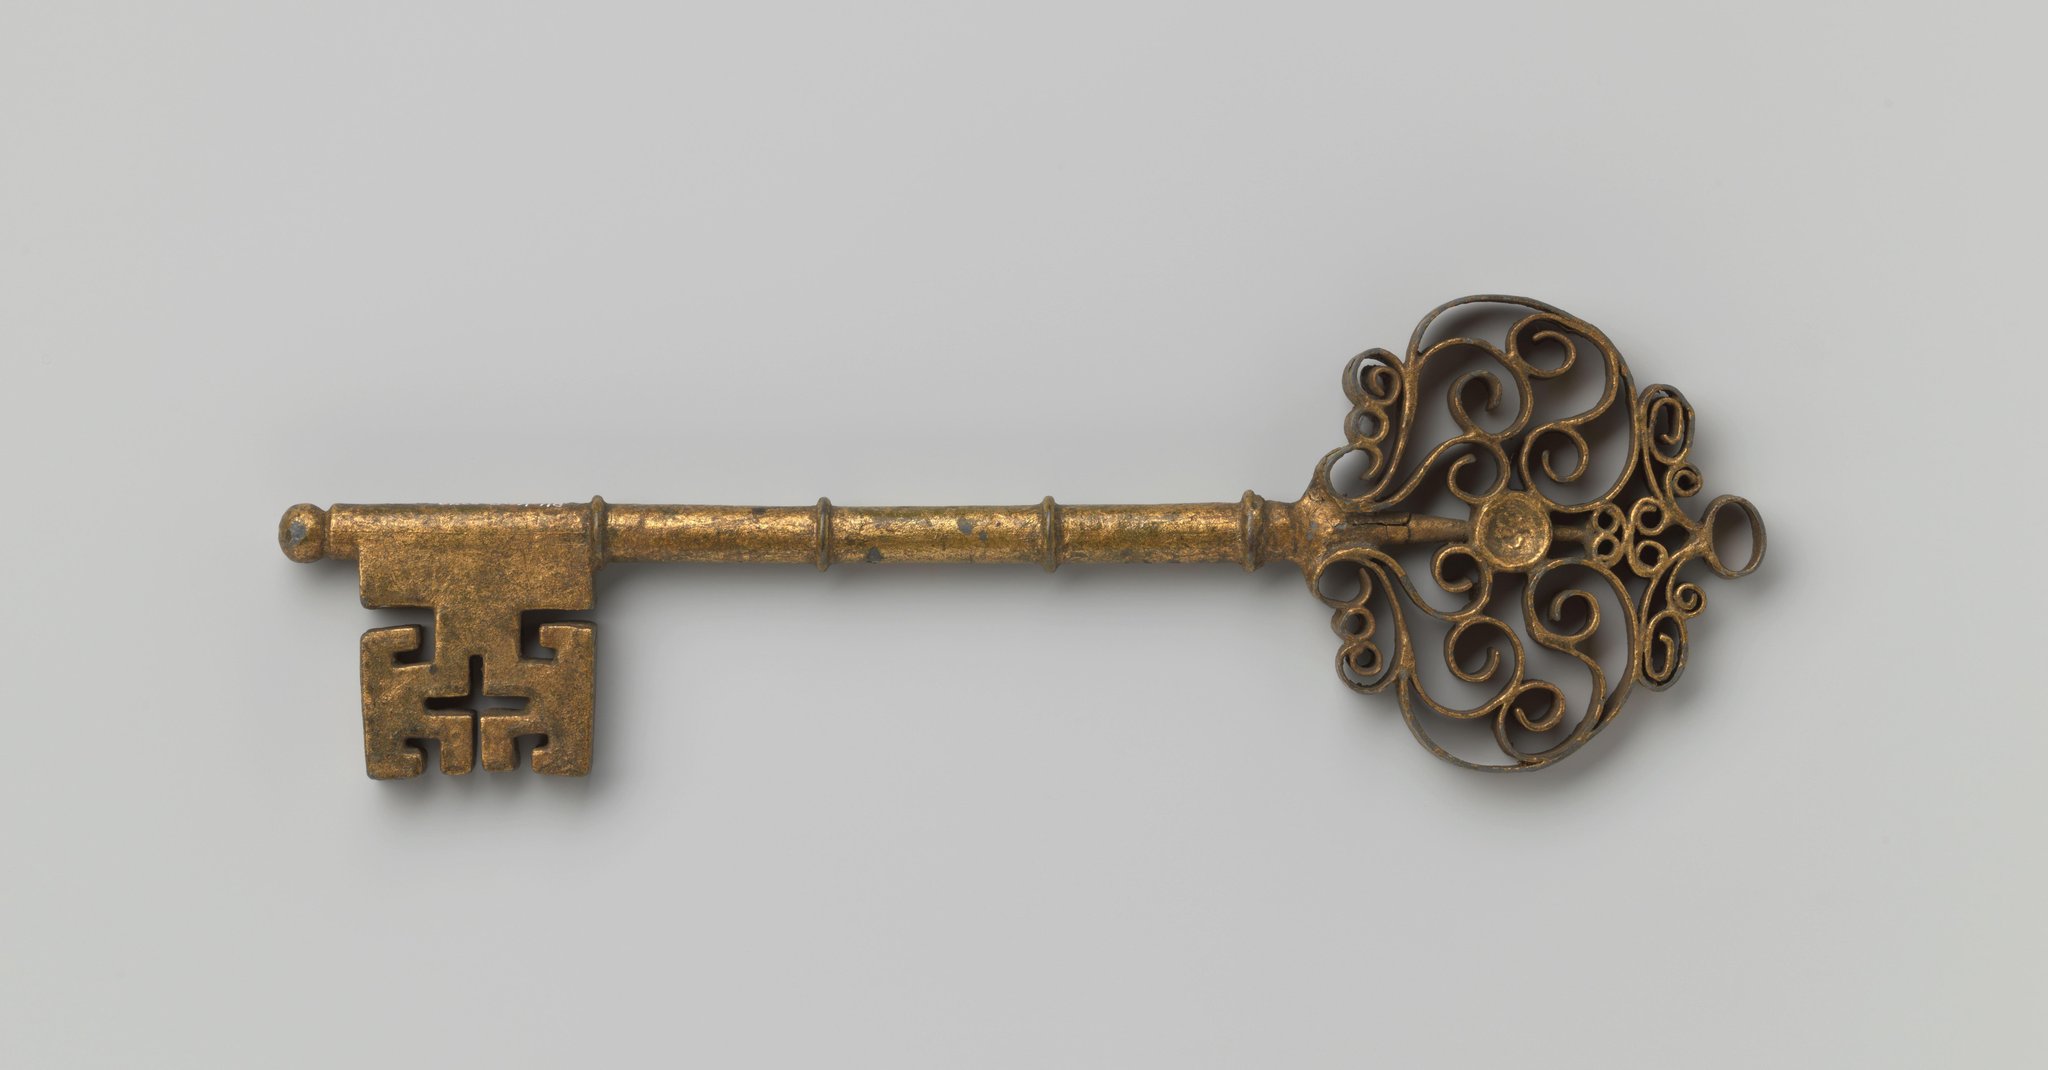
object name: uithangteken, uithangbord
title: Uithangteken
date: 1700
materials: iron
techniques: gilding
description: Uithangteken in de vorm van een sleutel, waarvan de ronde greep uit platte ijzeren krullen is samengesteld met bovenaan een oog. De schacht is door vier ringen in drie gelijke delen verdeeld.